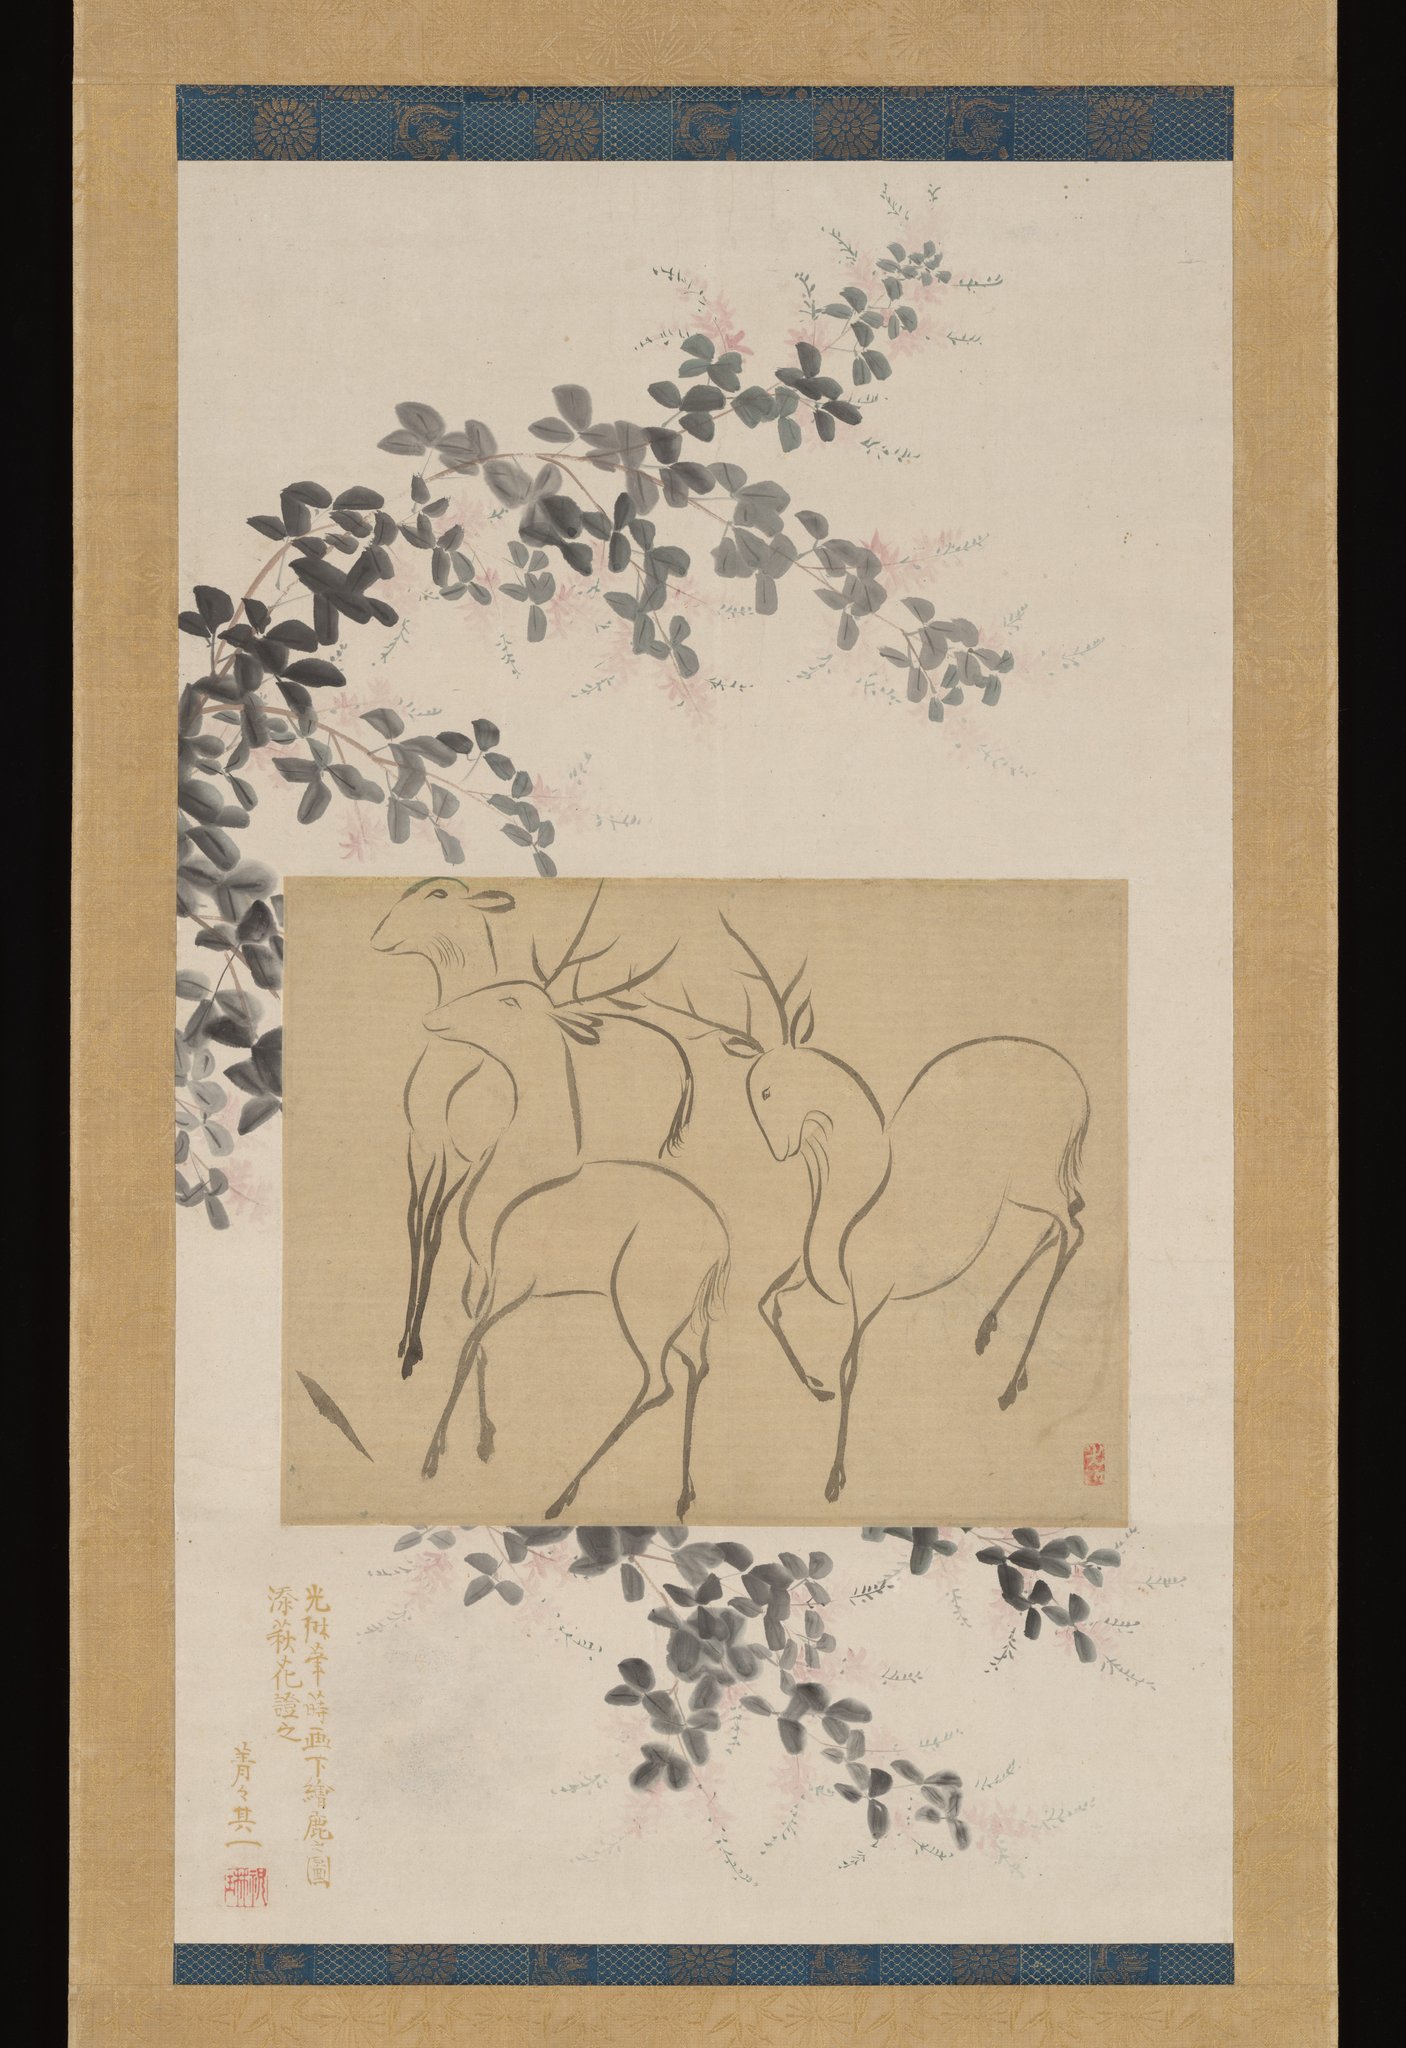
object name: hanging scroll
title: Preliminary Drawing of Three Deer Mounted on a Hanging-scroll Painting of Flowering Bush Clover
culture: japanese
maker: ogata kōrin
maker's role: artist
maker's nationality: japanese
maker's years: 1658-1716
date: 1701-1733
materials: gold, ink, paper, pigment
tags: deer